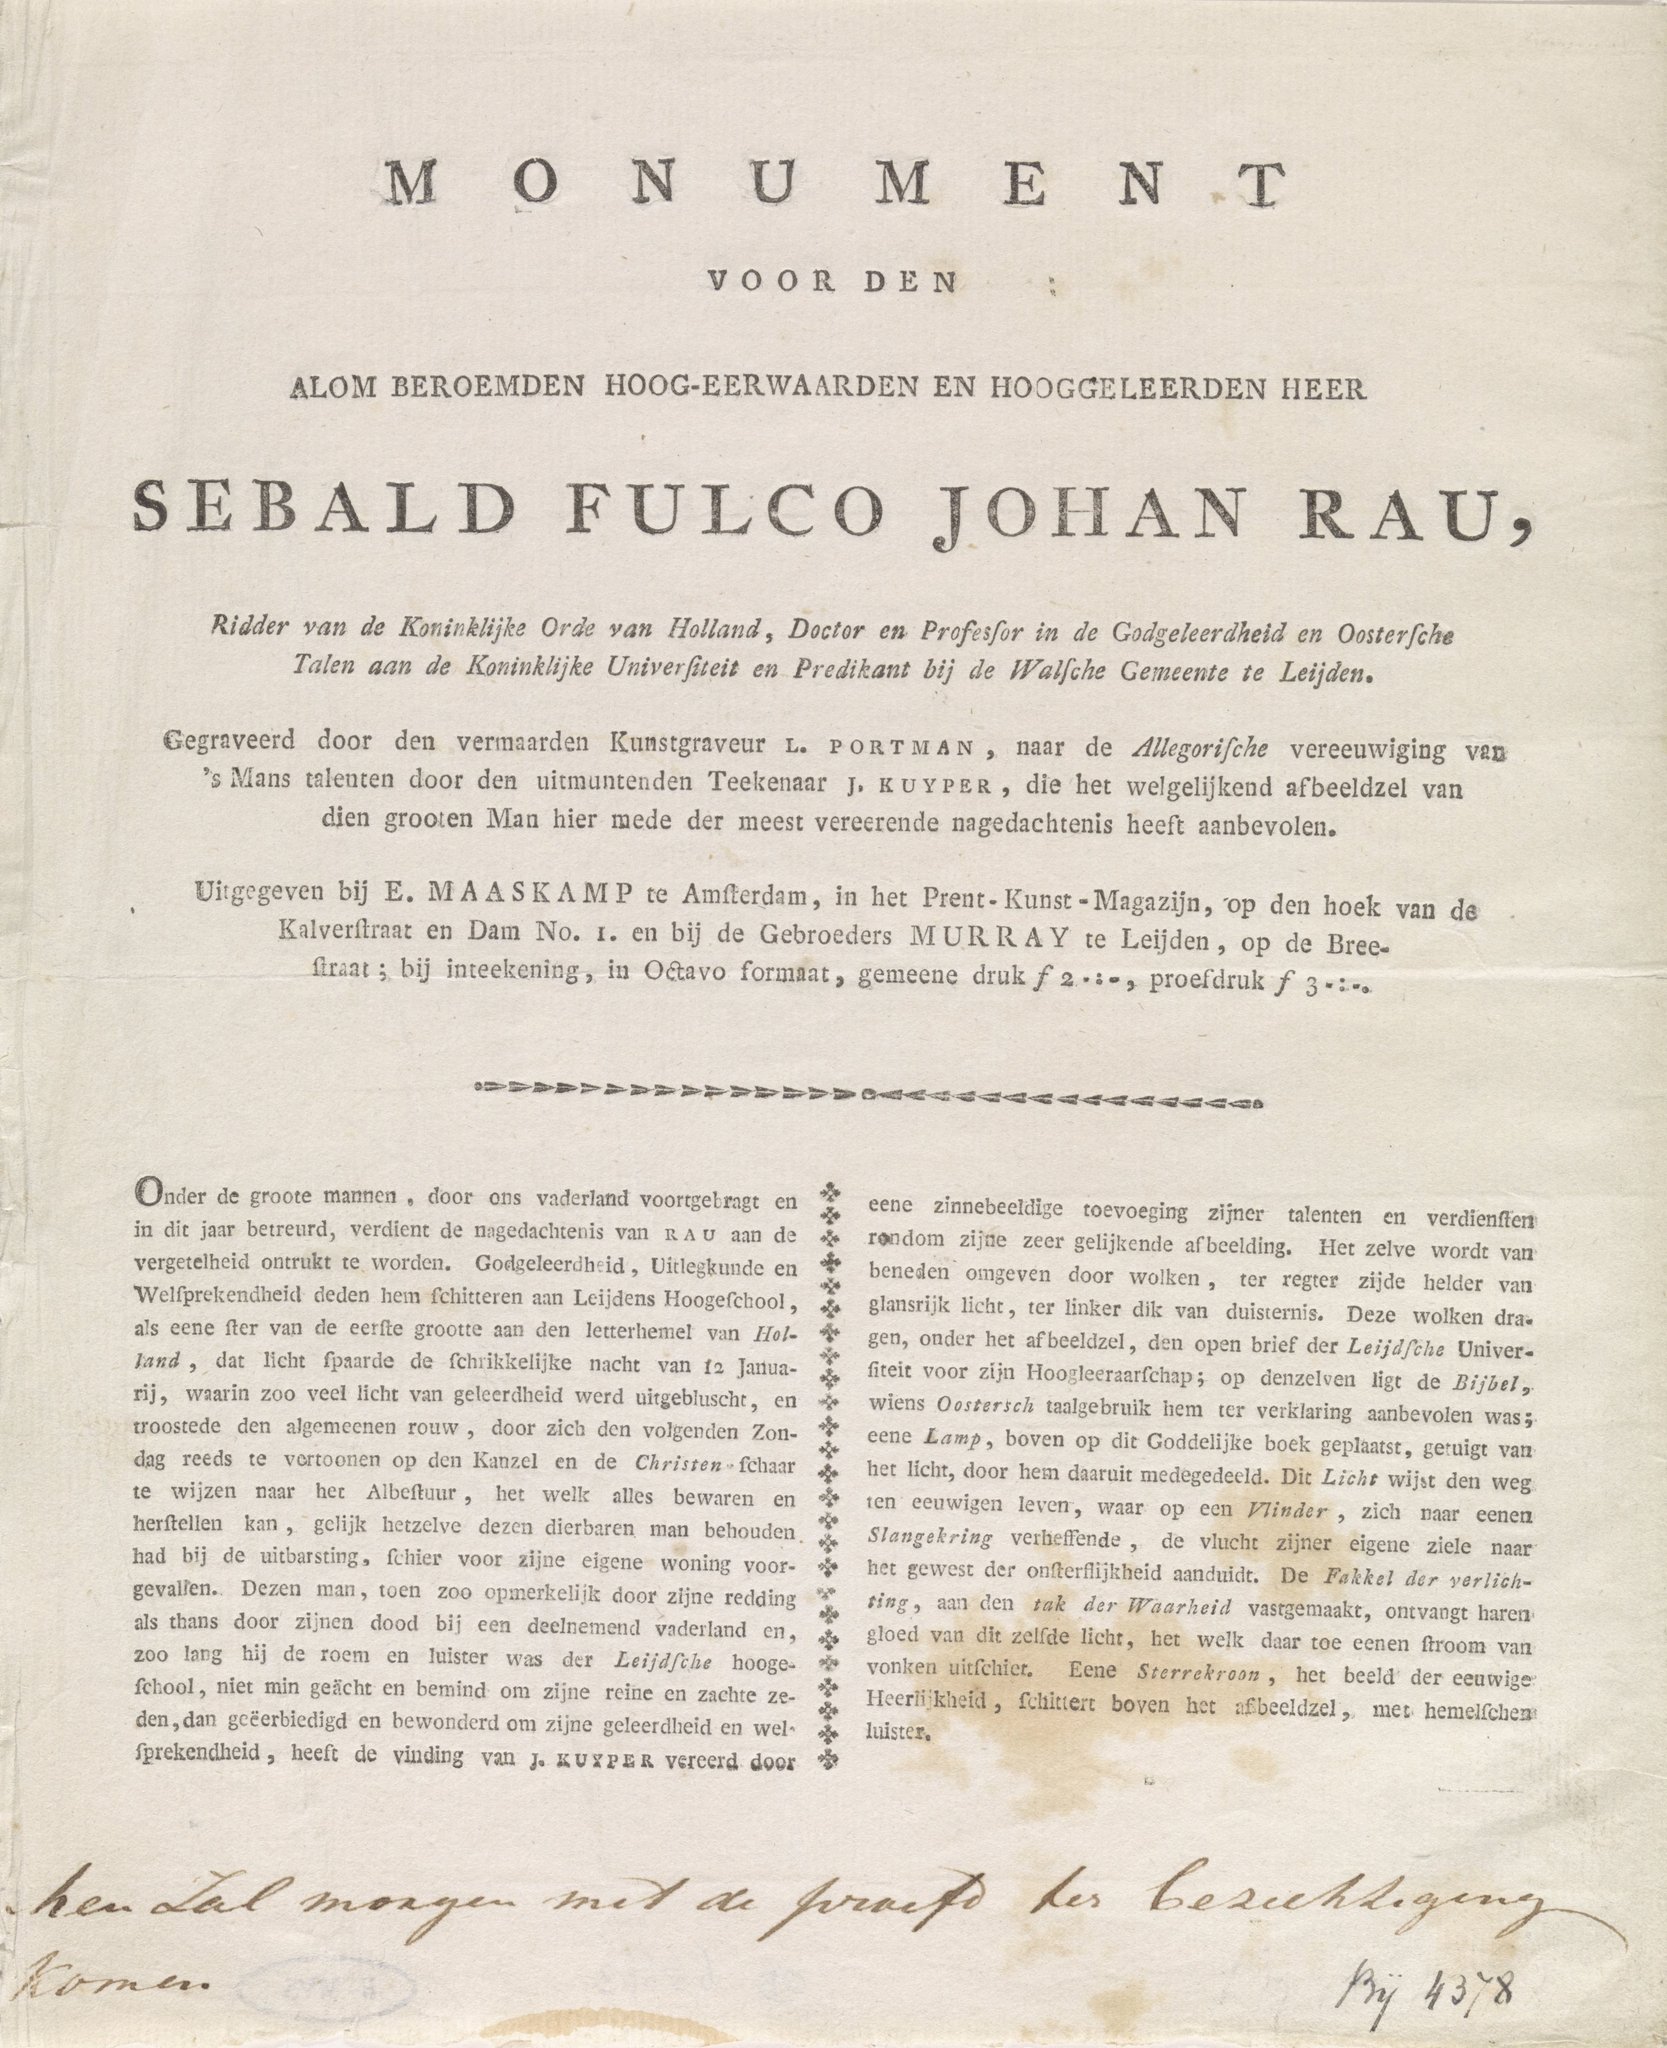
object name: text sheet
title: Tekstblad bij het allegorisch portret van de hoogleraar Sebald Fulco Johan Rau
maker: evert maaskamp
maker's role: draughtsman, painter, print maker, publisher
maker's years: 1769-1834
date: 1807-1828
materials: paper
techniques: letterpress printing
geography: amsterdam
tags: leiden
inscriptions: collector's mark: Lugt 2228, inscription: ‘Men zal morgen met de proefd ter bezichtiging komen.’, inscription: ‘Bij 4378’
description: Tekstblad met een toelichting in het Nederlands, in twee kolommen, op het allegorisch portret van Sebald Fulco Johan Rau.